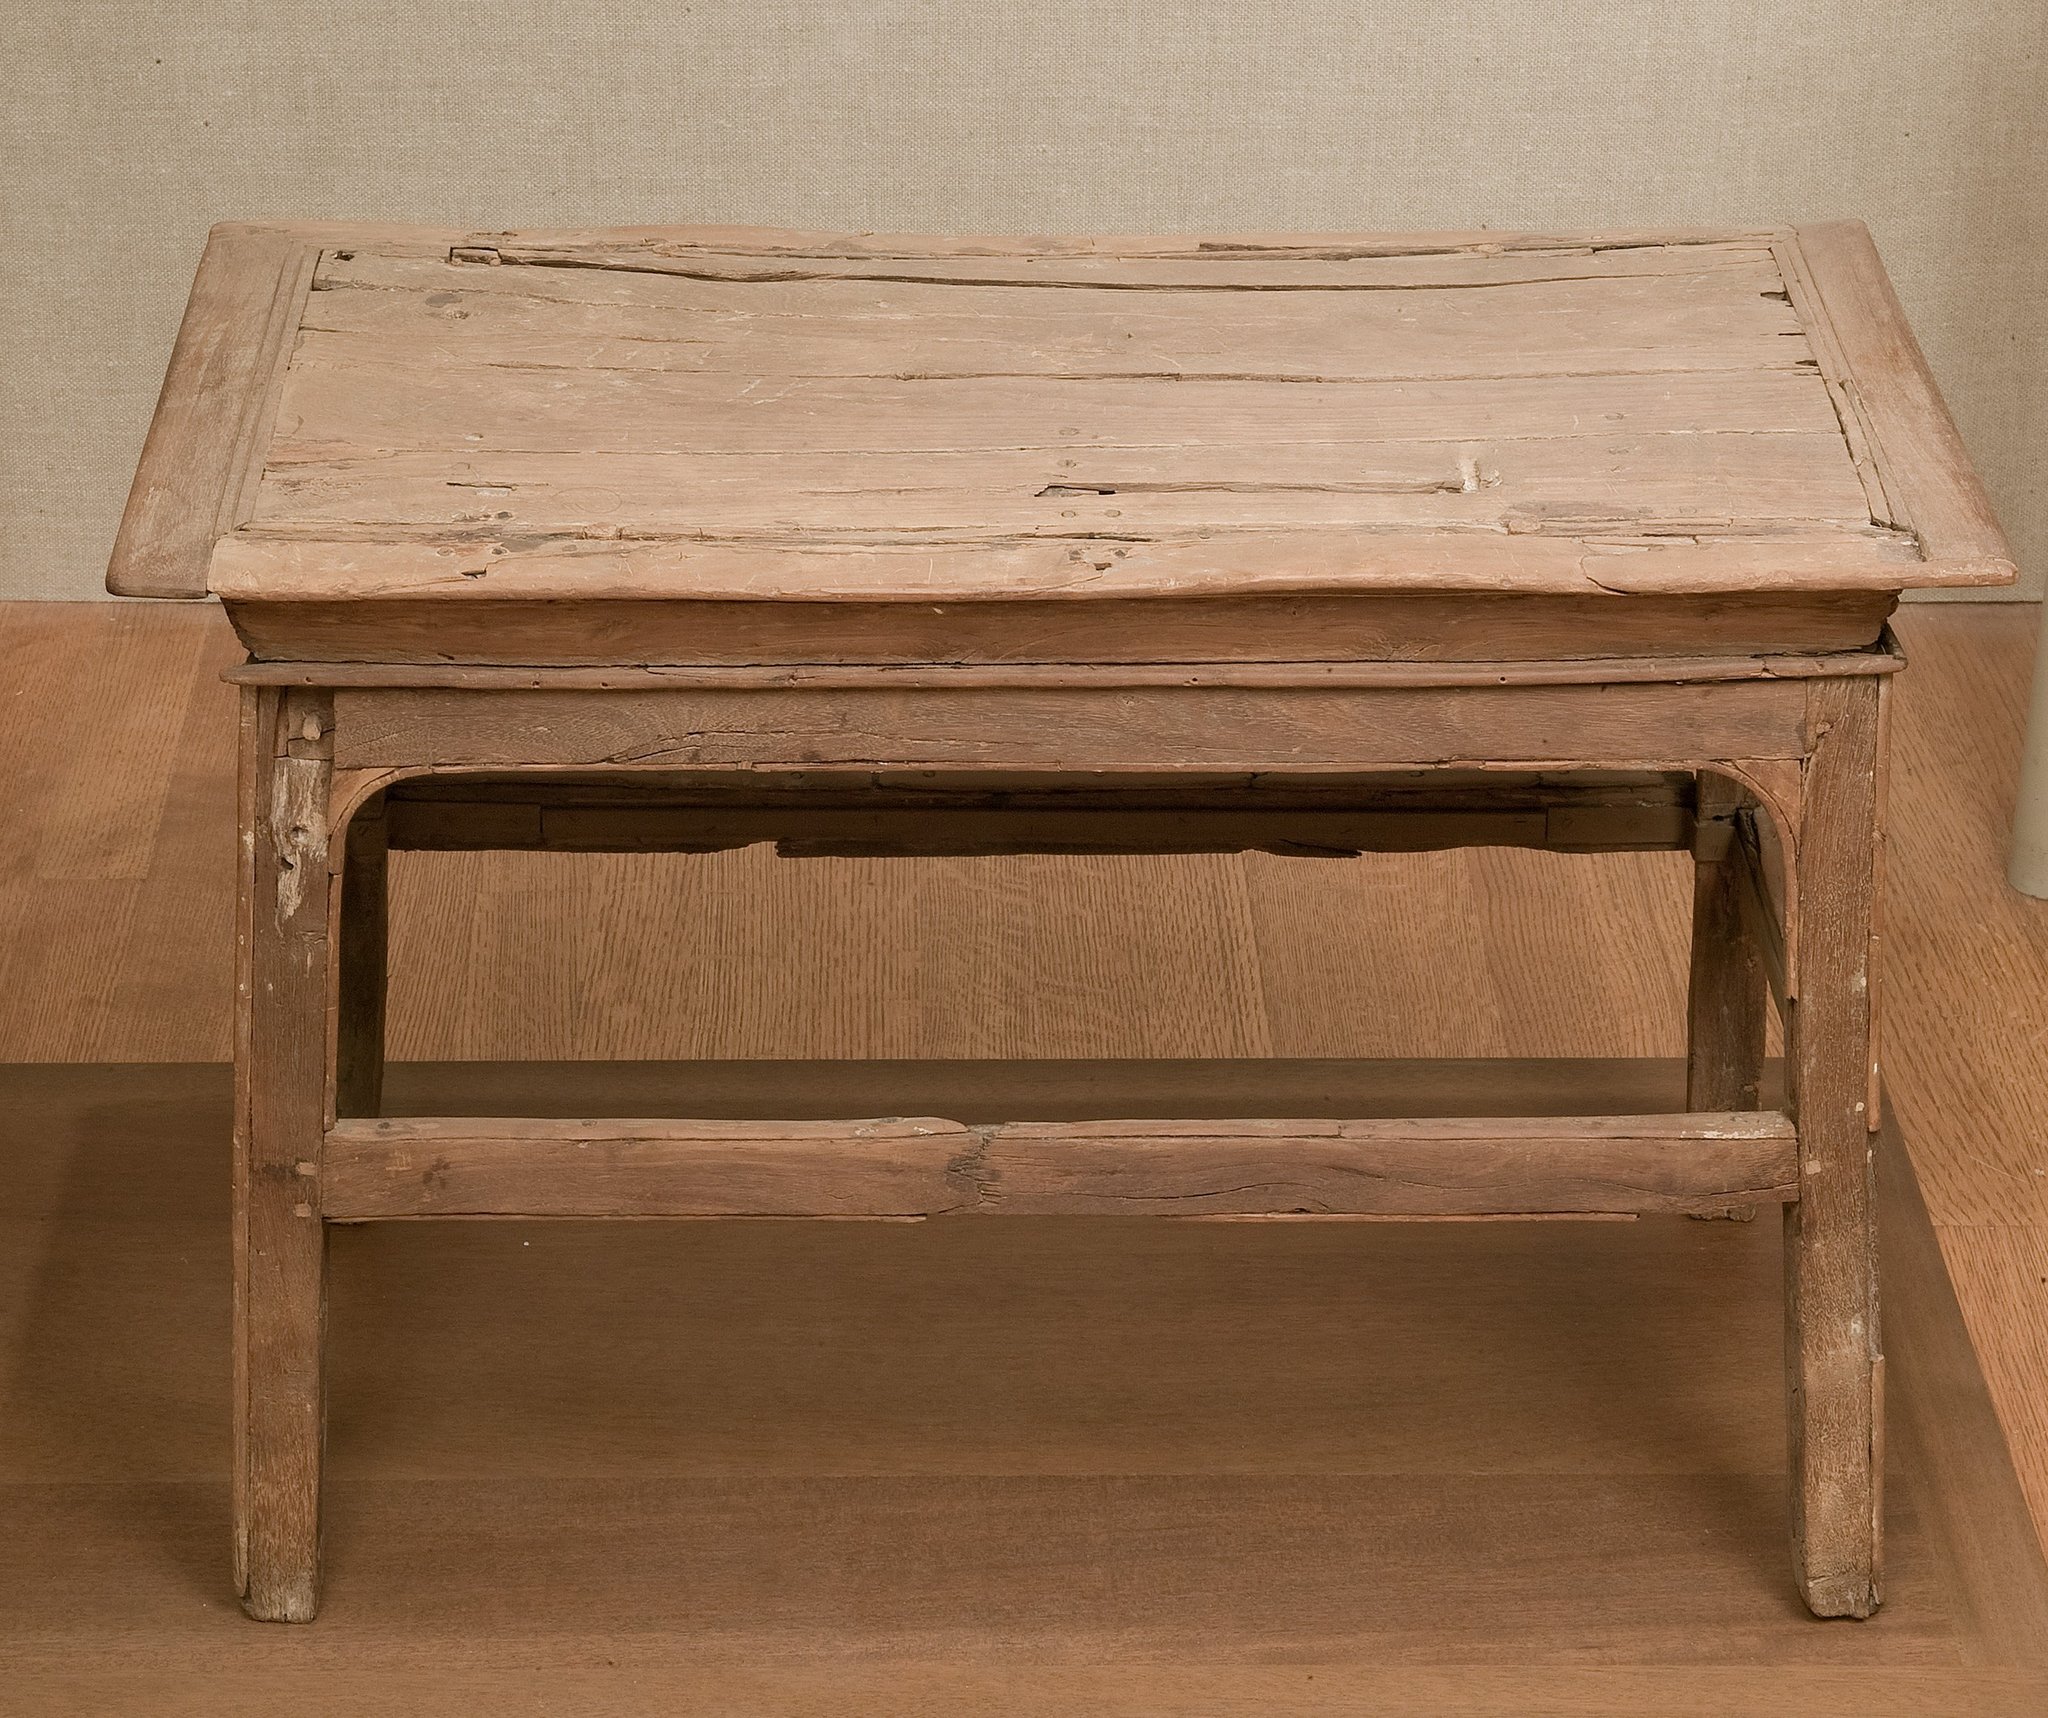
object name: table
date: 1700-1500 BCE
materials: wood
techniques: inlay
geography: egypt